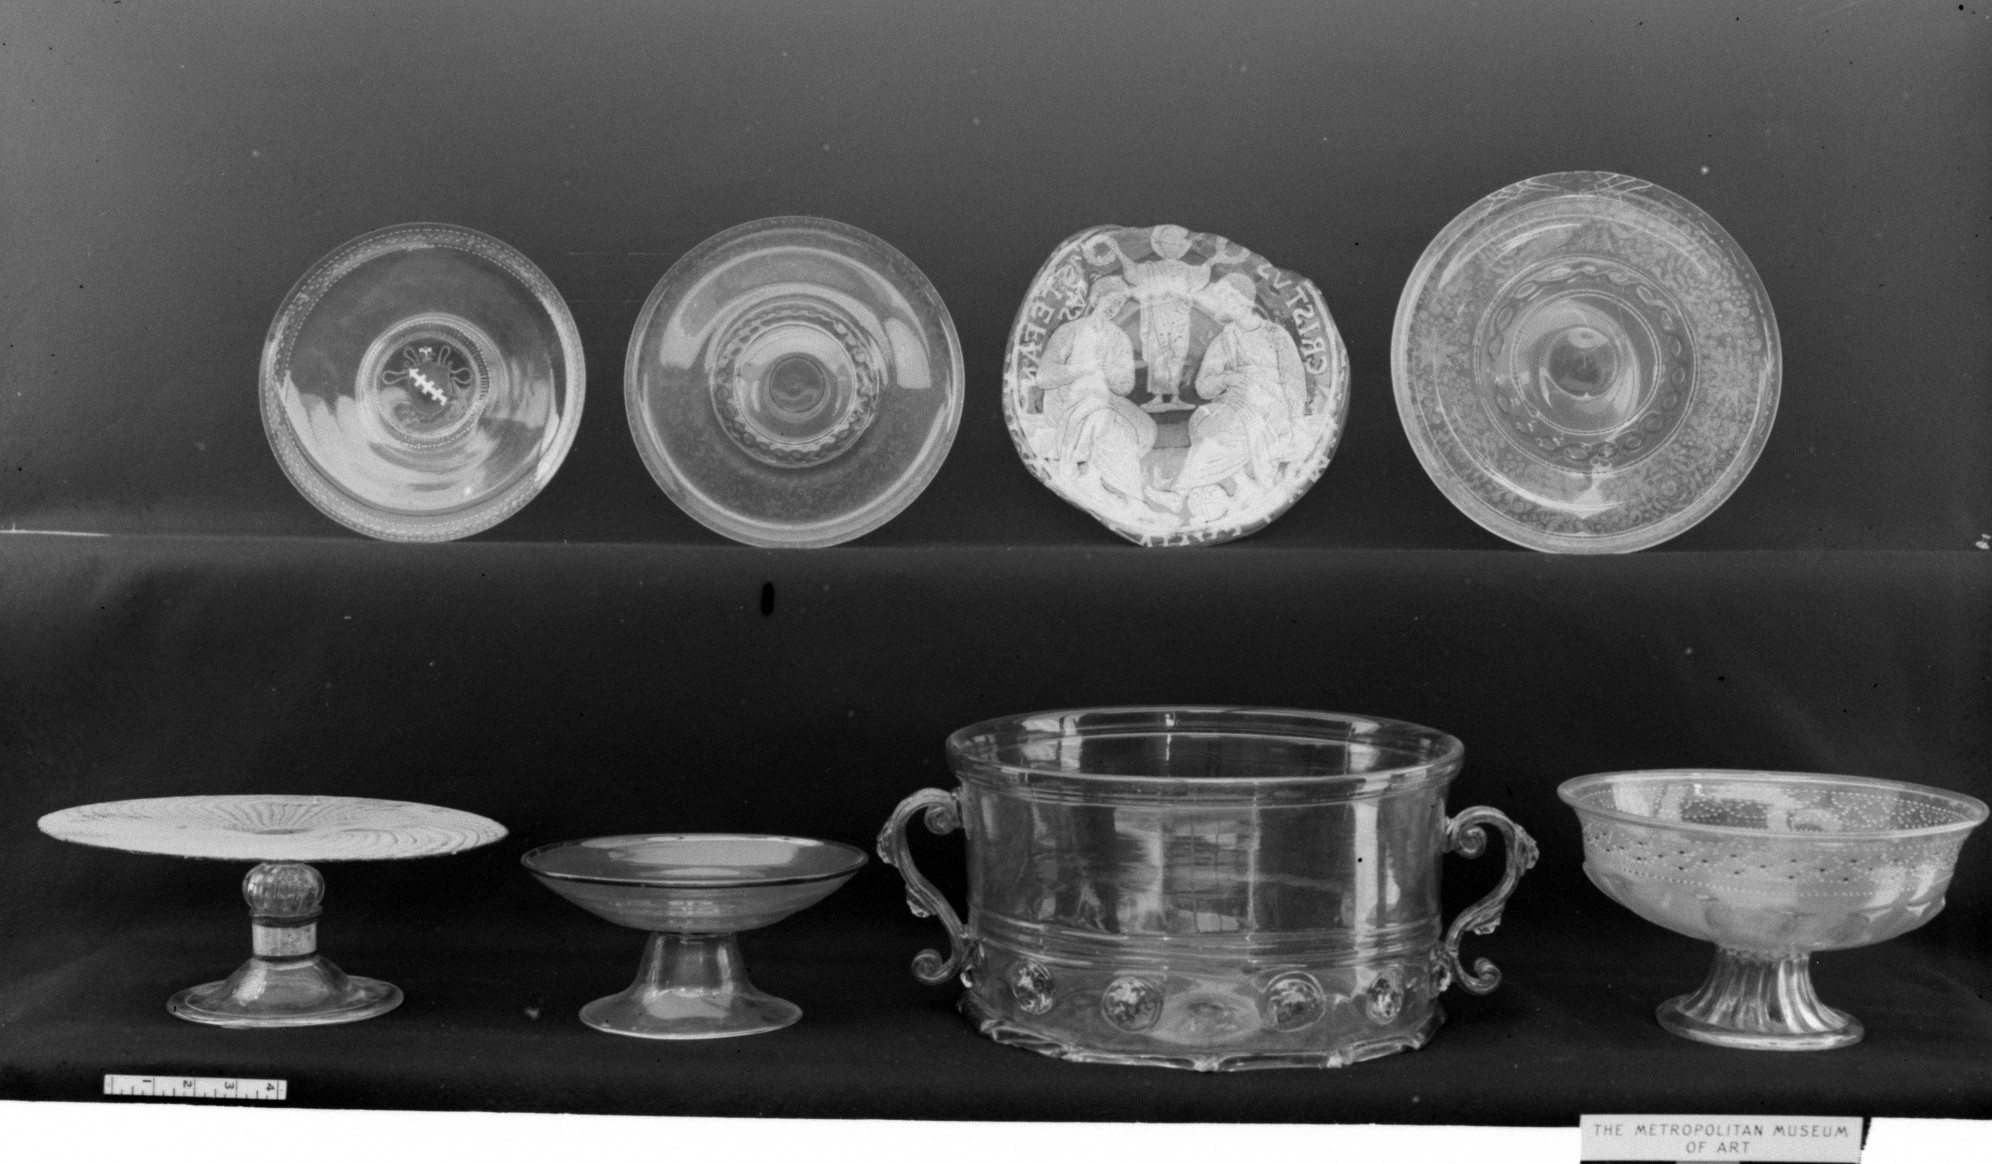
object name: tazza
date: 1801-1900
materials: glass